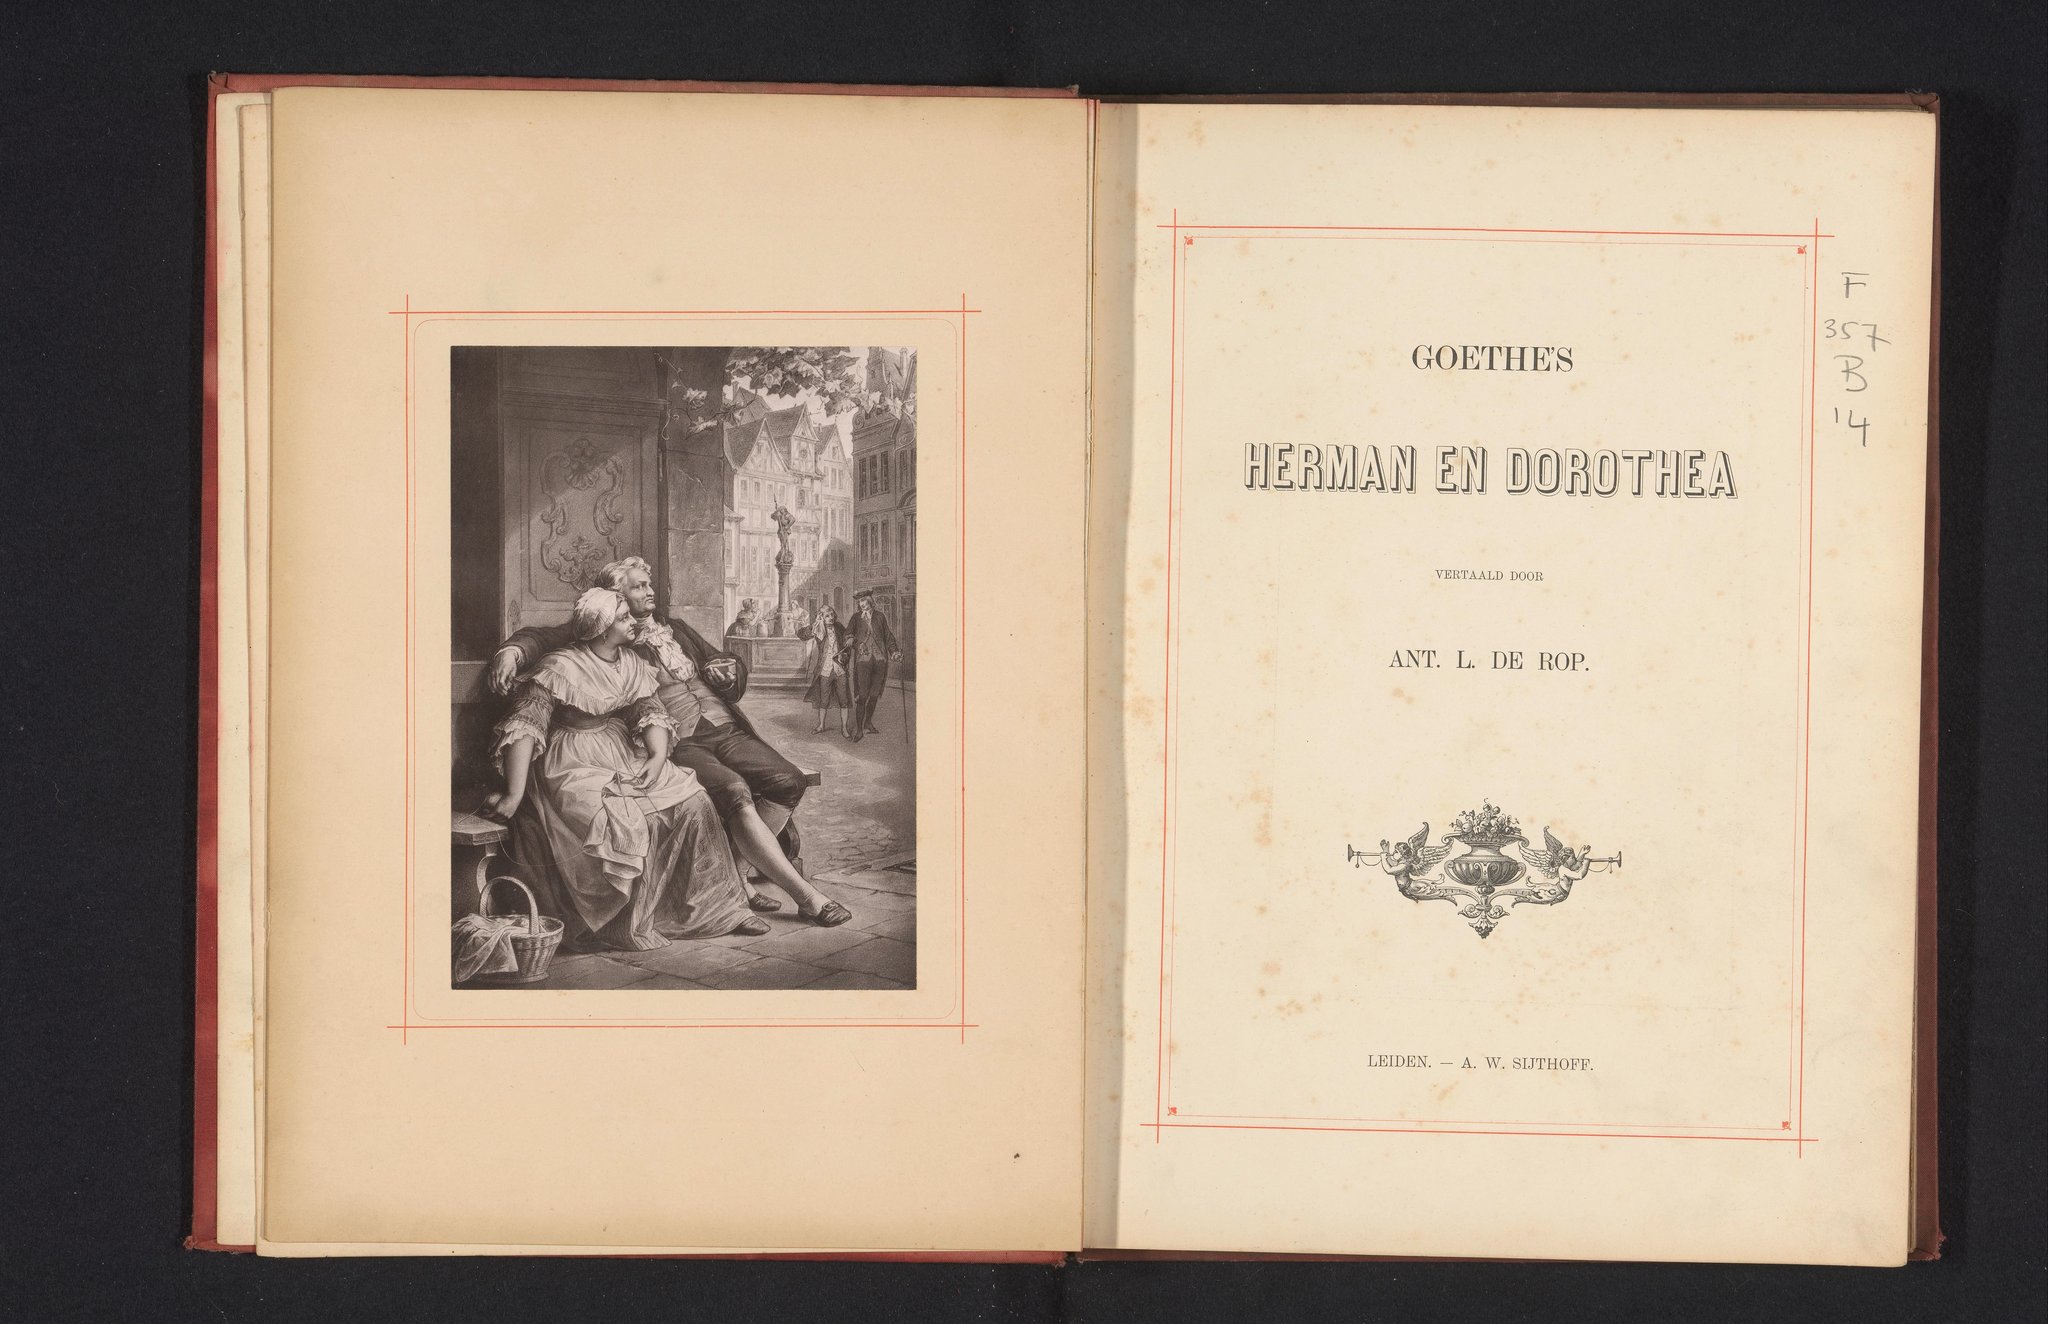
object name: page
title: Fotoreproductie van een tekening, voorstellende de ouders van Hermann op een bank naast een plein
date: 1875-1885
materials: paper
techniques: photograph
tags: bench, marriage, married couple, 'matrimonium'